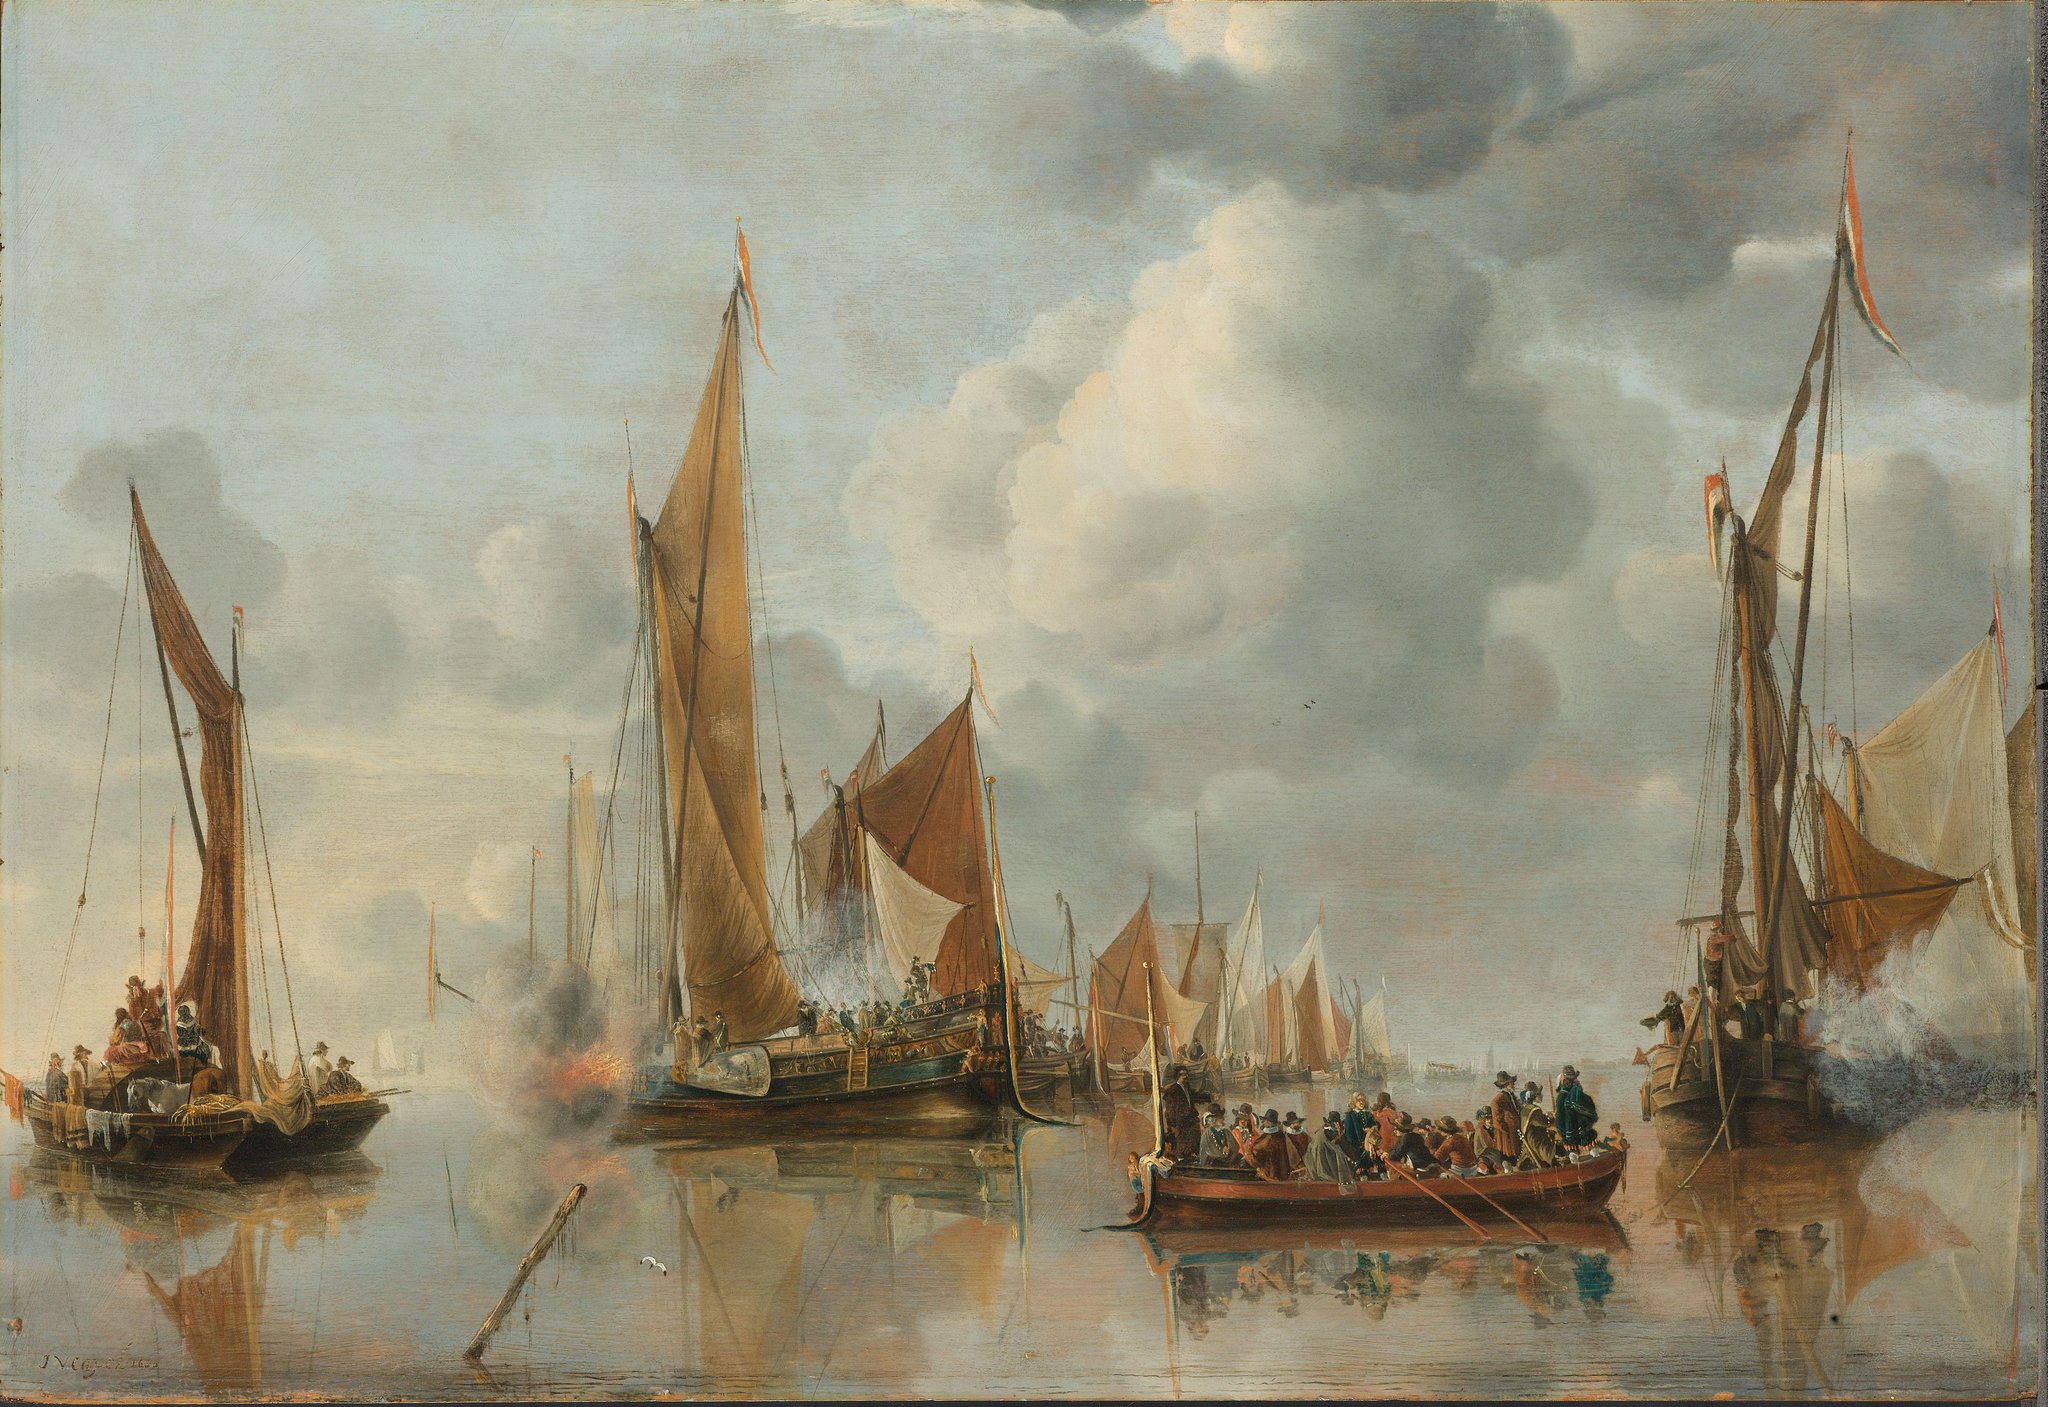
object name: painting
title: The Home Fleet Saluting the State Barge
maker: jan van de cappelle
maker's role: draughtsman, print maker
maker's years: 1624-1679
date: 1650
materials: oil, panel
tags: sailing-ship, sailing-boat, military salutes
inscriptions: signature and date: ‘Jvcapel 1650’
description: A row of ships lies at anchor. Two yachts fire a salute for the functionaries rowing by in a state barge. The water’s smooth, mirror-like surface reflects the vessel and its passengers. Van de Cappelle superbly captured the grandeur unfolding on the water, with ships as far as the eye can see rendered in perspective, under an imposing cloudy sky.